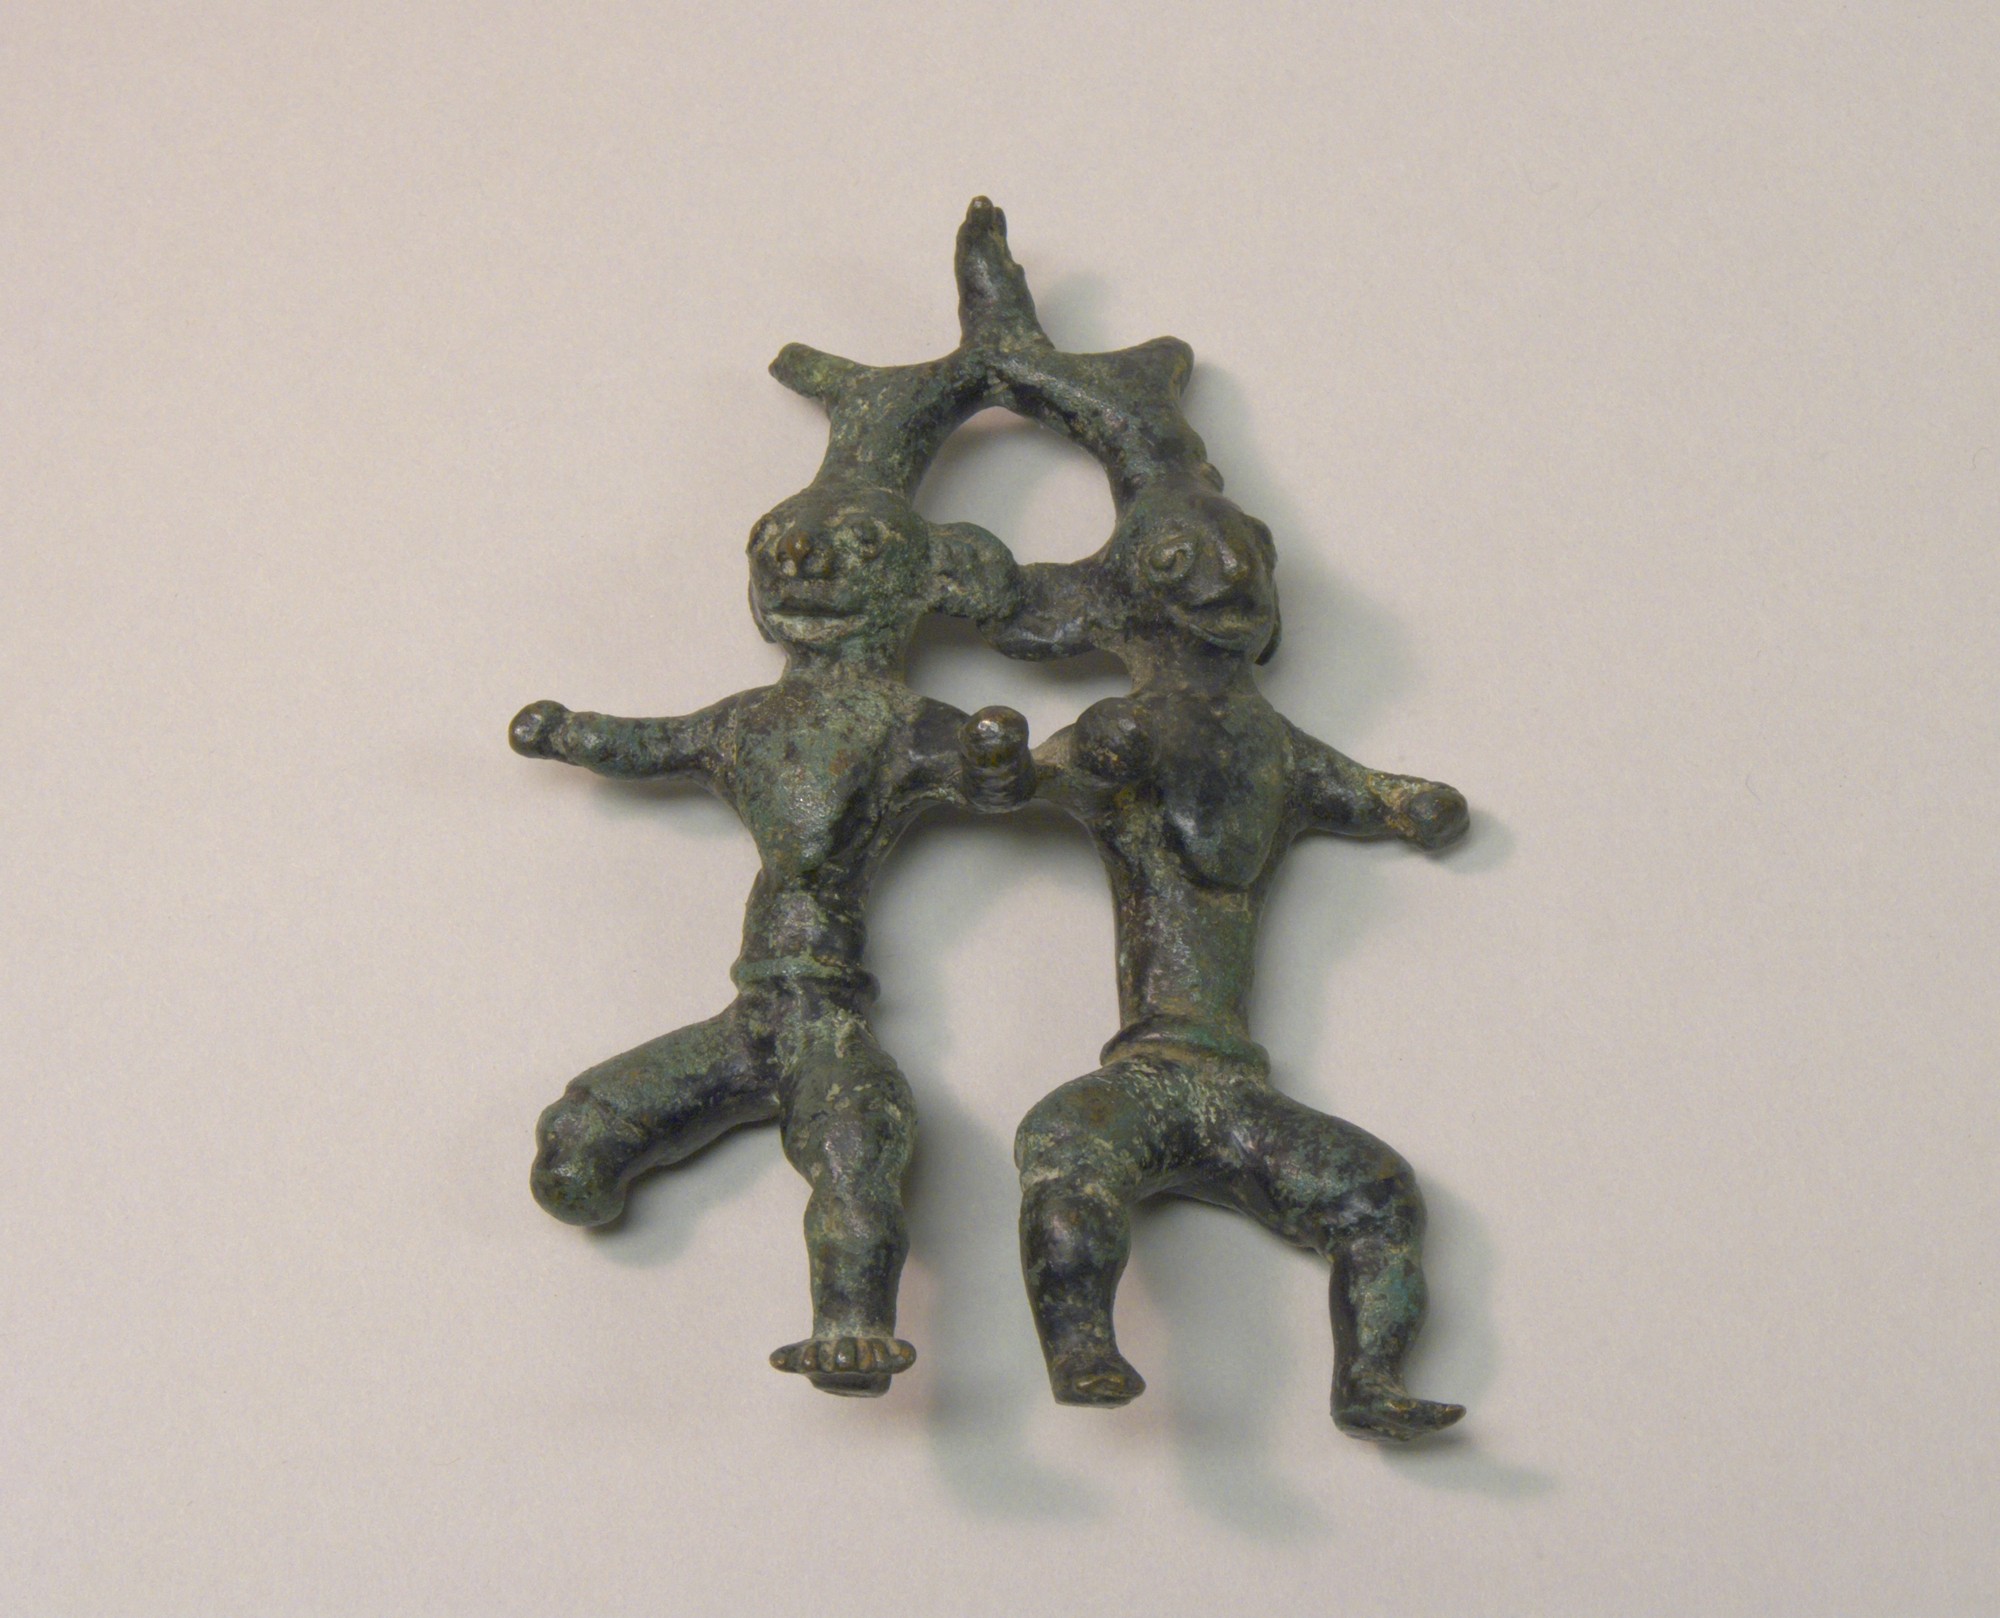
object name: group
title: Joined Figures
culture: indonesian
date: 500 BCE-300 CE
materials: bronze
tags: human figures